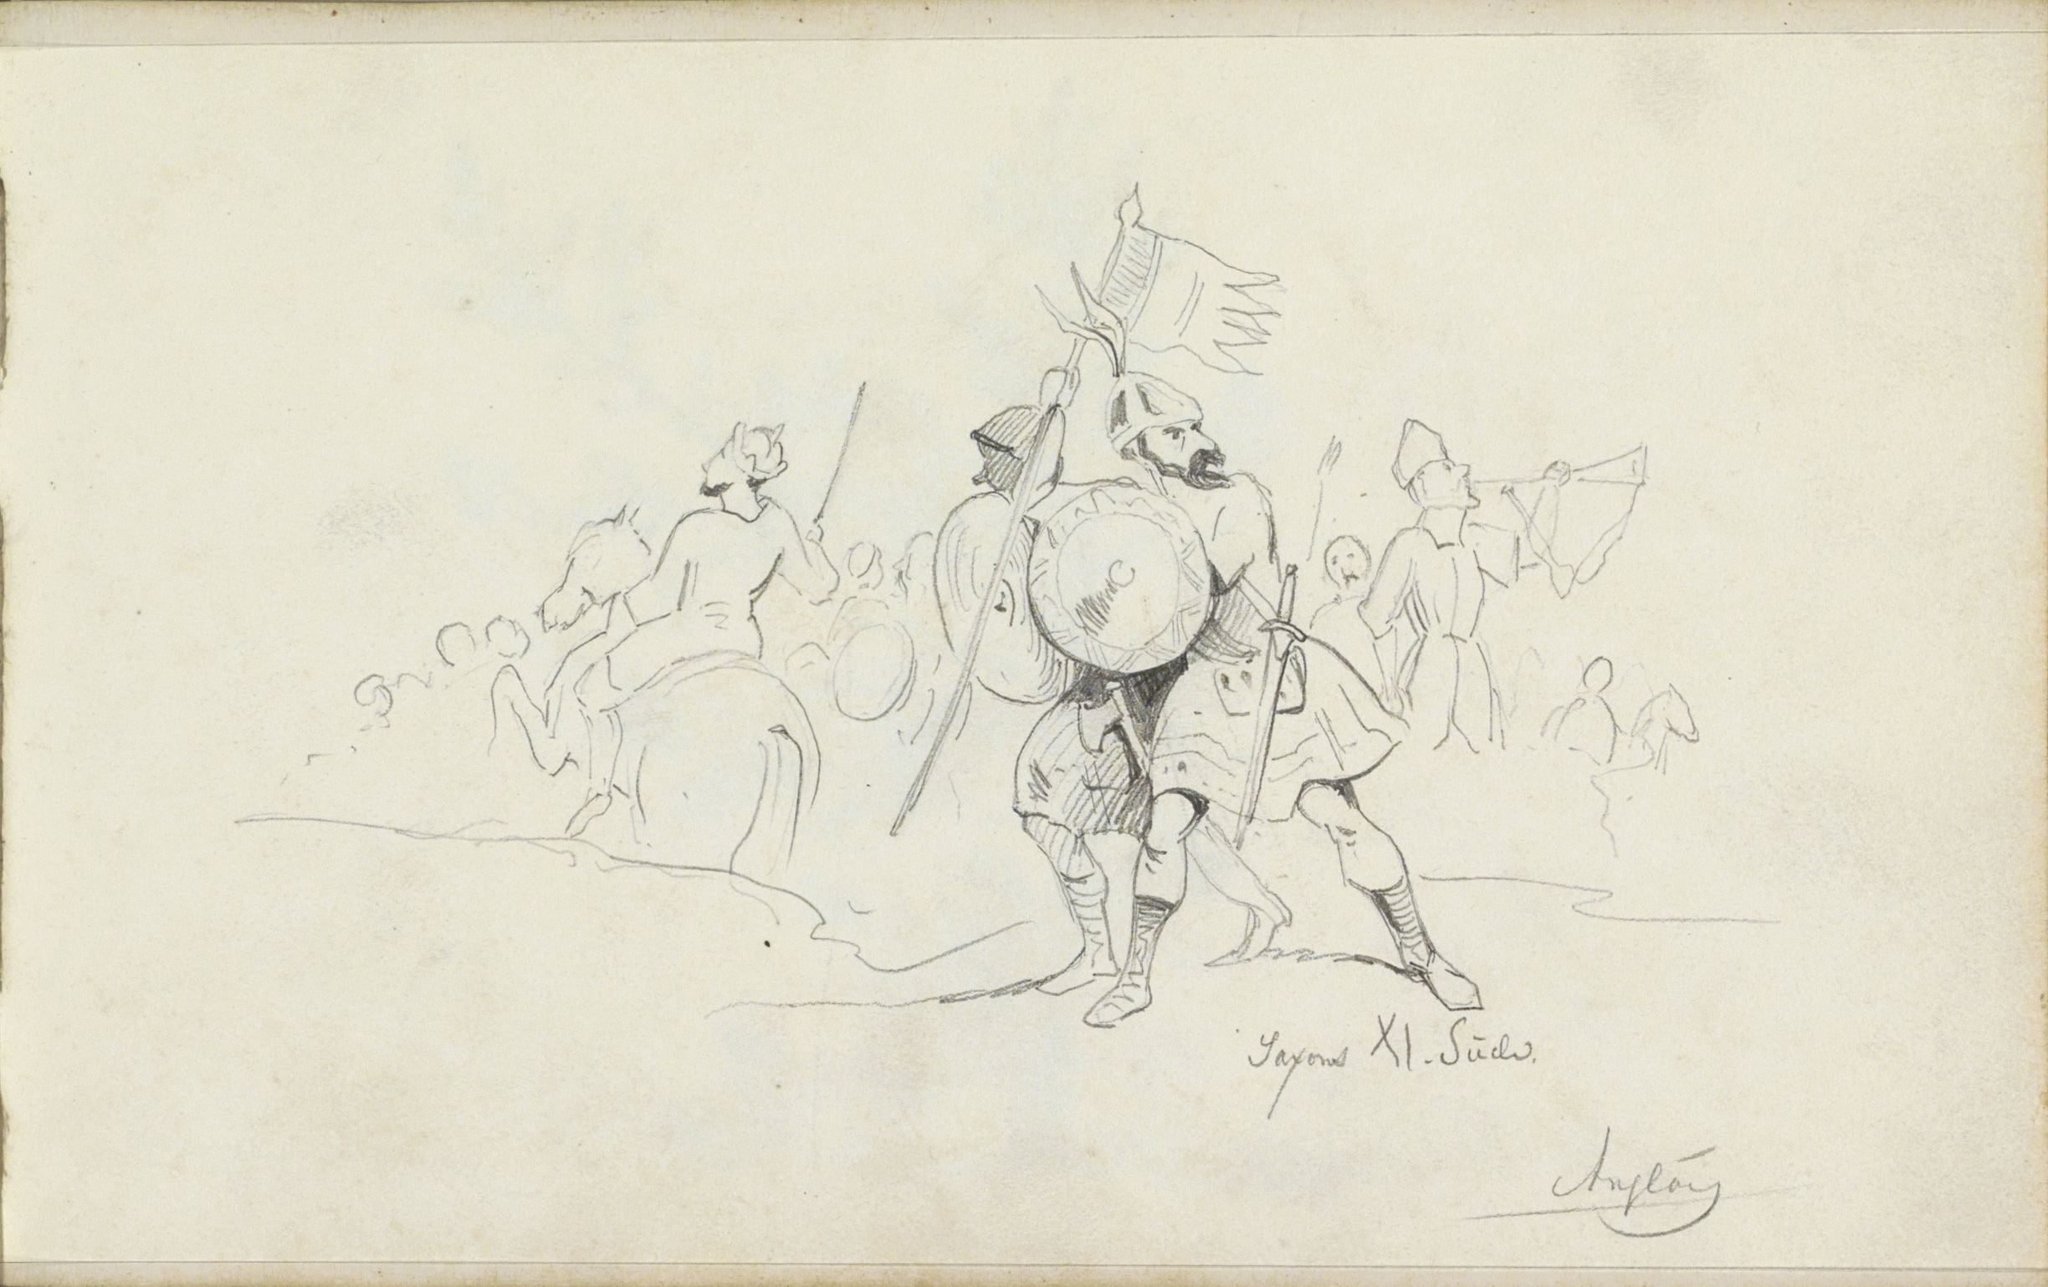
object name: sketchbook leaf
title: Strijd van de Saksen in de elfde eeuw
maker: johannes tavenraat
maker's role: draughtsman, painter, print maker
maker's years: 1809-1881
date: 1843-1844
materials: paper, pencil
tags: riding a horse, ass, or mule; rider, horseman, protective weapons: shield, battle, fighting in general, knight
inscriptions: annotation: ‘saxons XI. Siecle/ Anglais’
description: Vermoedelijk getekend naar voorbeelden uit het boek 'Medieval Knights and Armour' van Samuel Rush Meyrick. Blad 25 recto uit een schetsboek met 38 bladen.